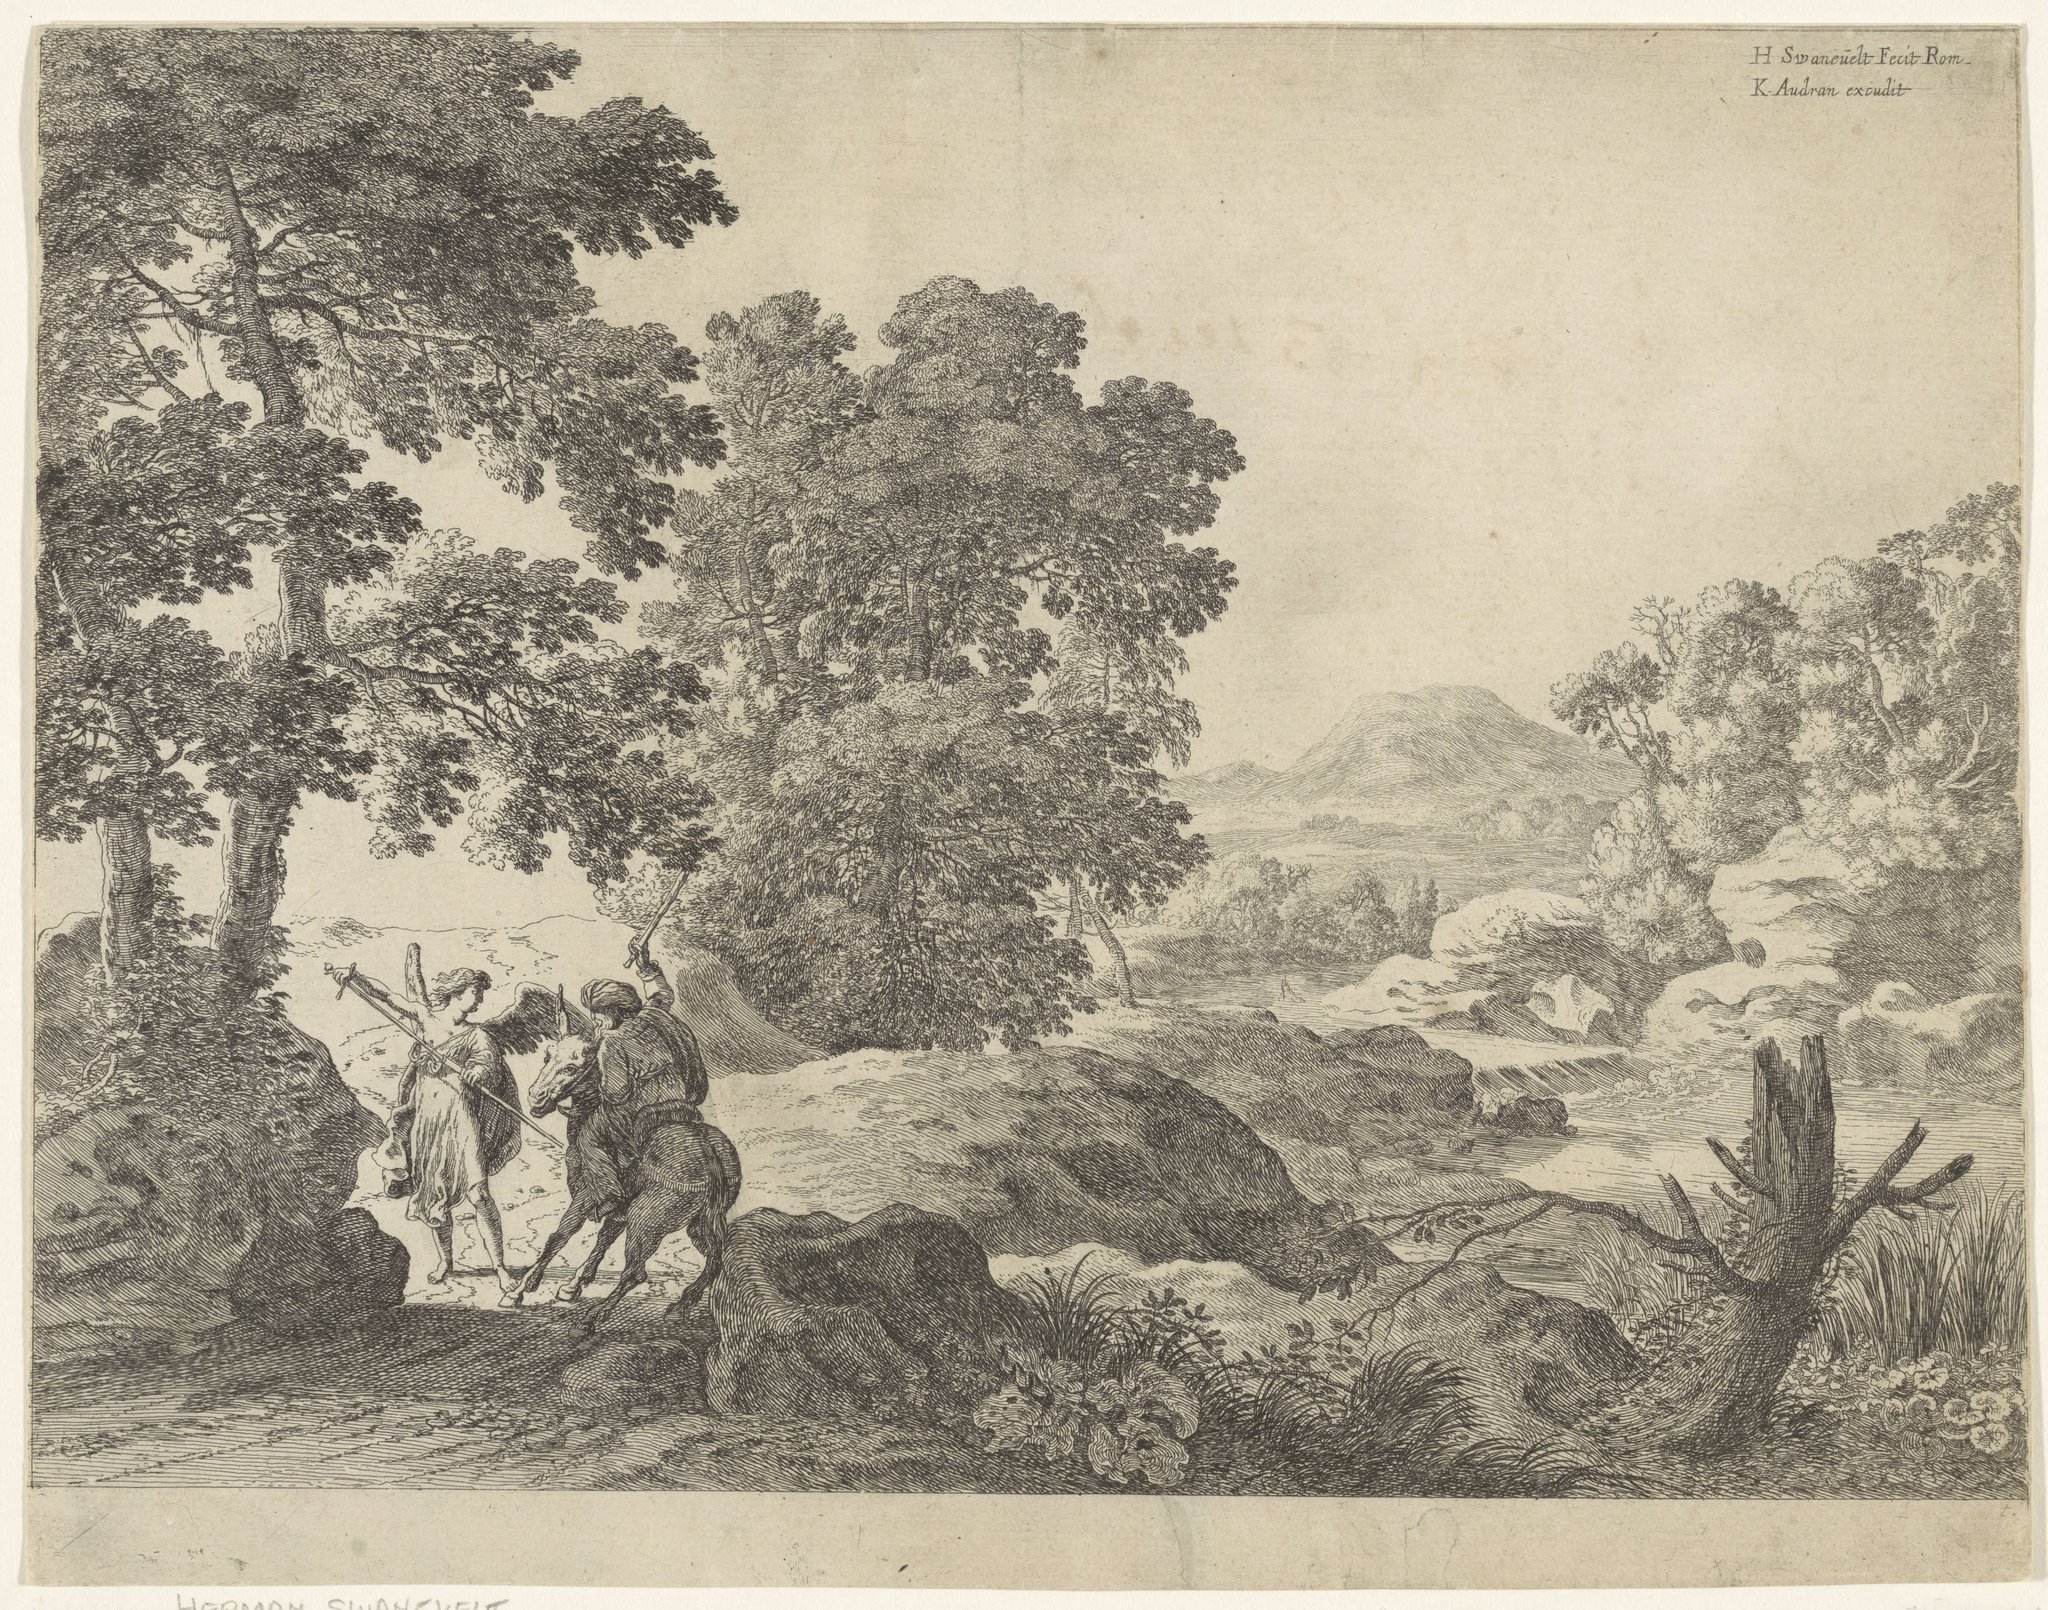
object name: print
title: Oudtestamentische voorstellingen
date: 1629-1641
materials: paper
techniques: engraving, etching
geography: rome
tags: ass, donkey, an angel holding a sword bars the way and causes balaam's ass to turn aside; the angel is invisible to balaam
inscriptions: collector's mark: Lugt 2228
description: In een heuvelachtig landschap met boompartijen is links op de voorgrond Bileam zittend op een terugdeinzende ezel weergegeven. In zijn rechterhand houdt hij een zwaard en voor hem staat een engel die een zwaard uit de schede trekt.